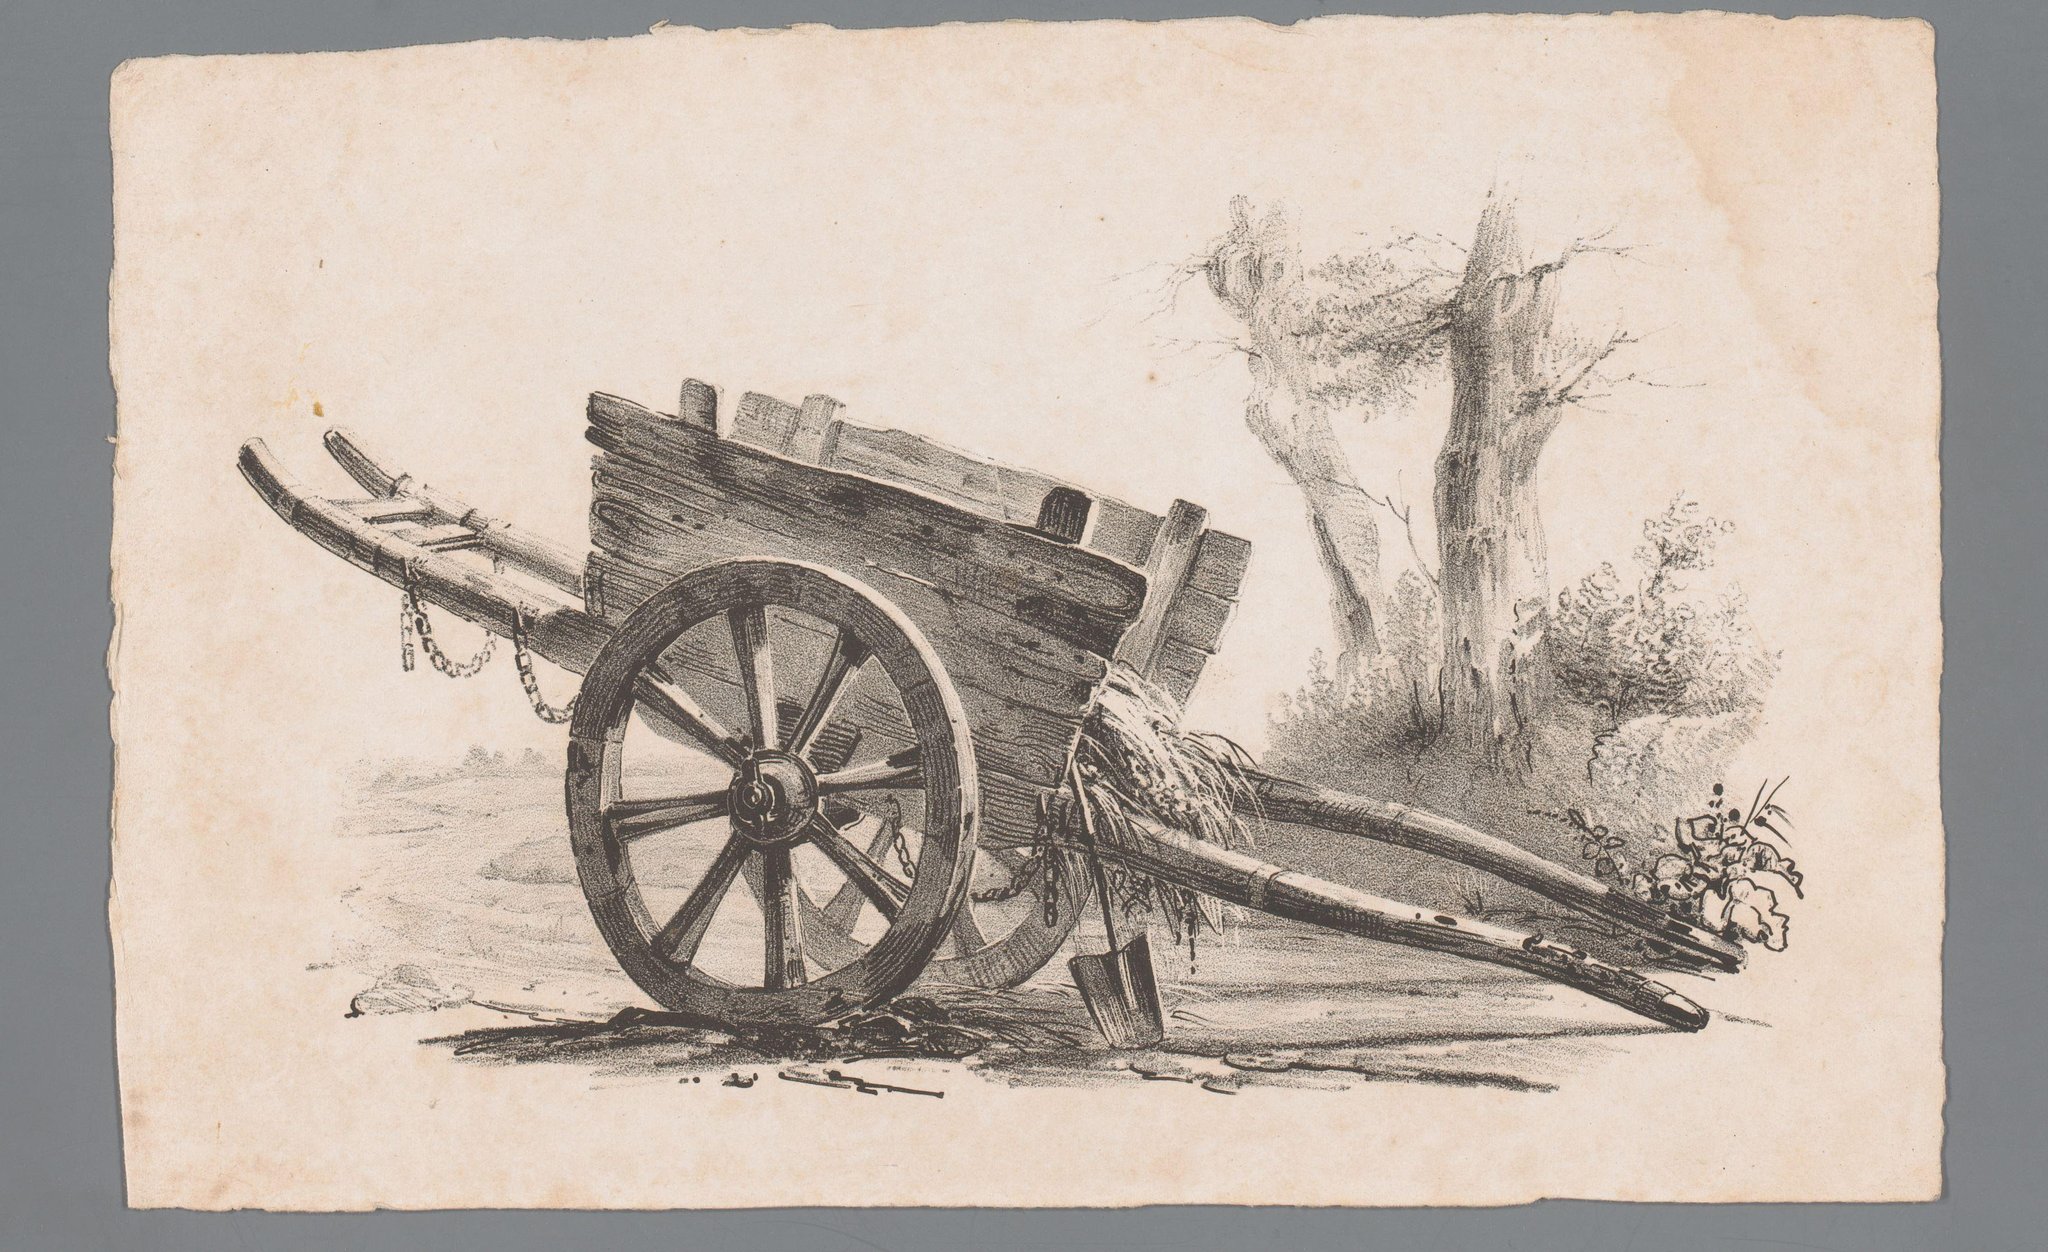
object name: print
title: Wagen met twee wielen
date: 1827-1851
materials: paper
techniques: lithograph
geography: brussels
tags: two-wheeled, animal-drawn vehicle, gardening-tools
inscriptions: collector's mark: Lugt 2228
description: Prent behoort mogelijk tot de serie 'Principes de paysages' vervaardigd door Paulus Lauters.